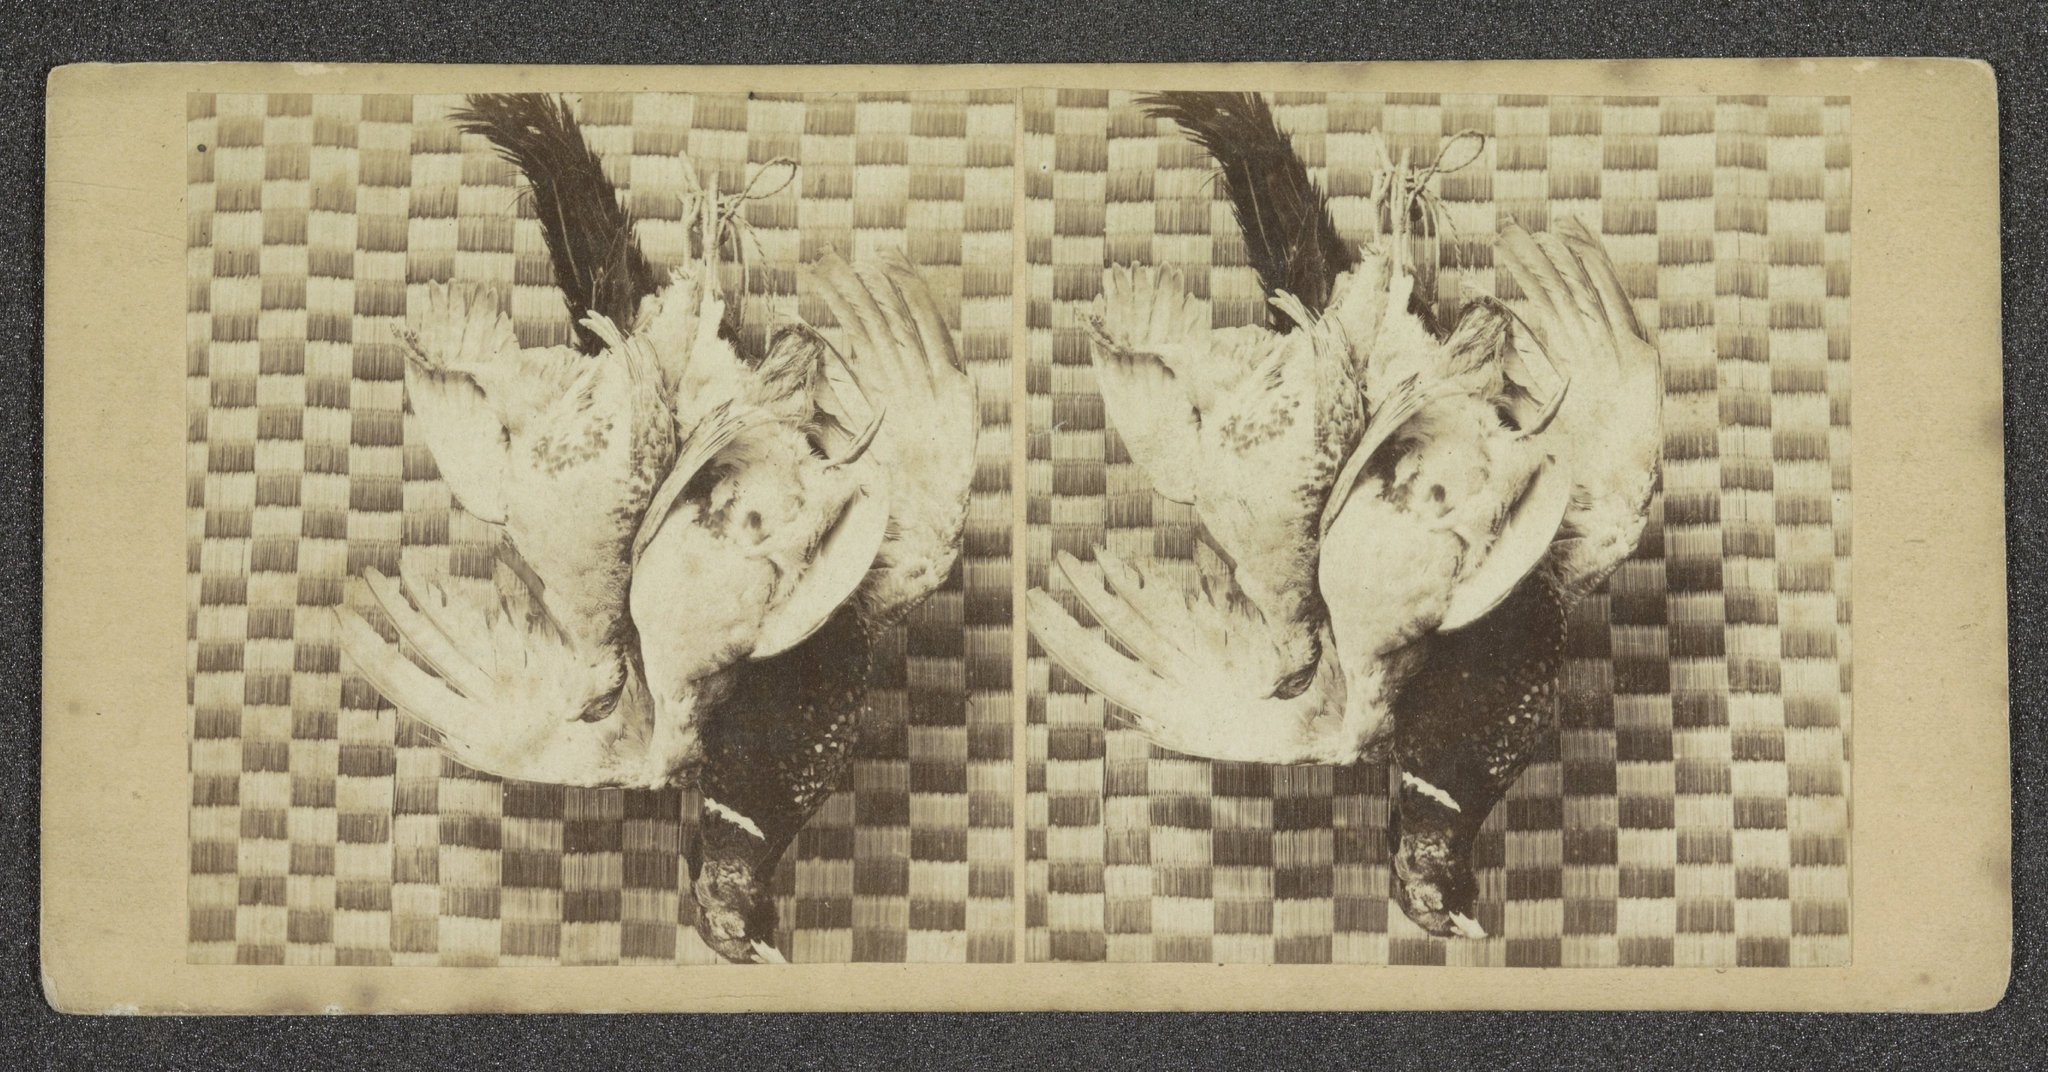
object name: stereograph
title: Stilleven met gevogelte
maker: Anonymous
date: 1857-1870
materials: cardboard, paper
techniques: albumen print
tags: birds, meat; still life of meat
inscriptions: name: ‘PAUL FLEURY’